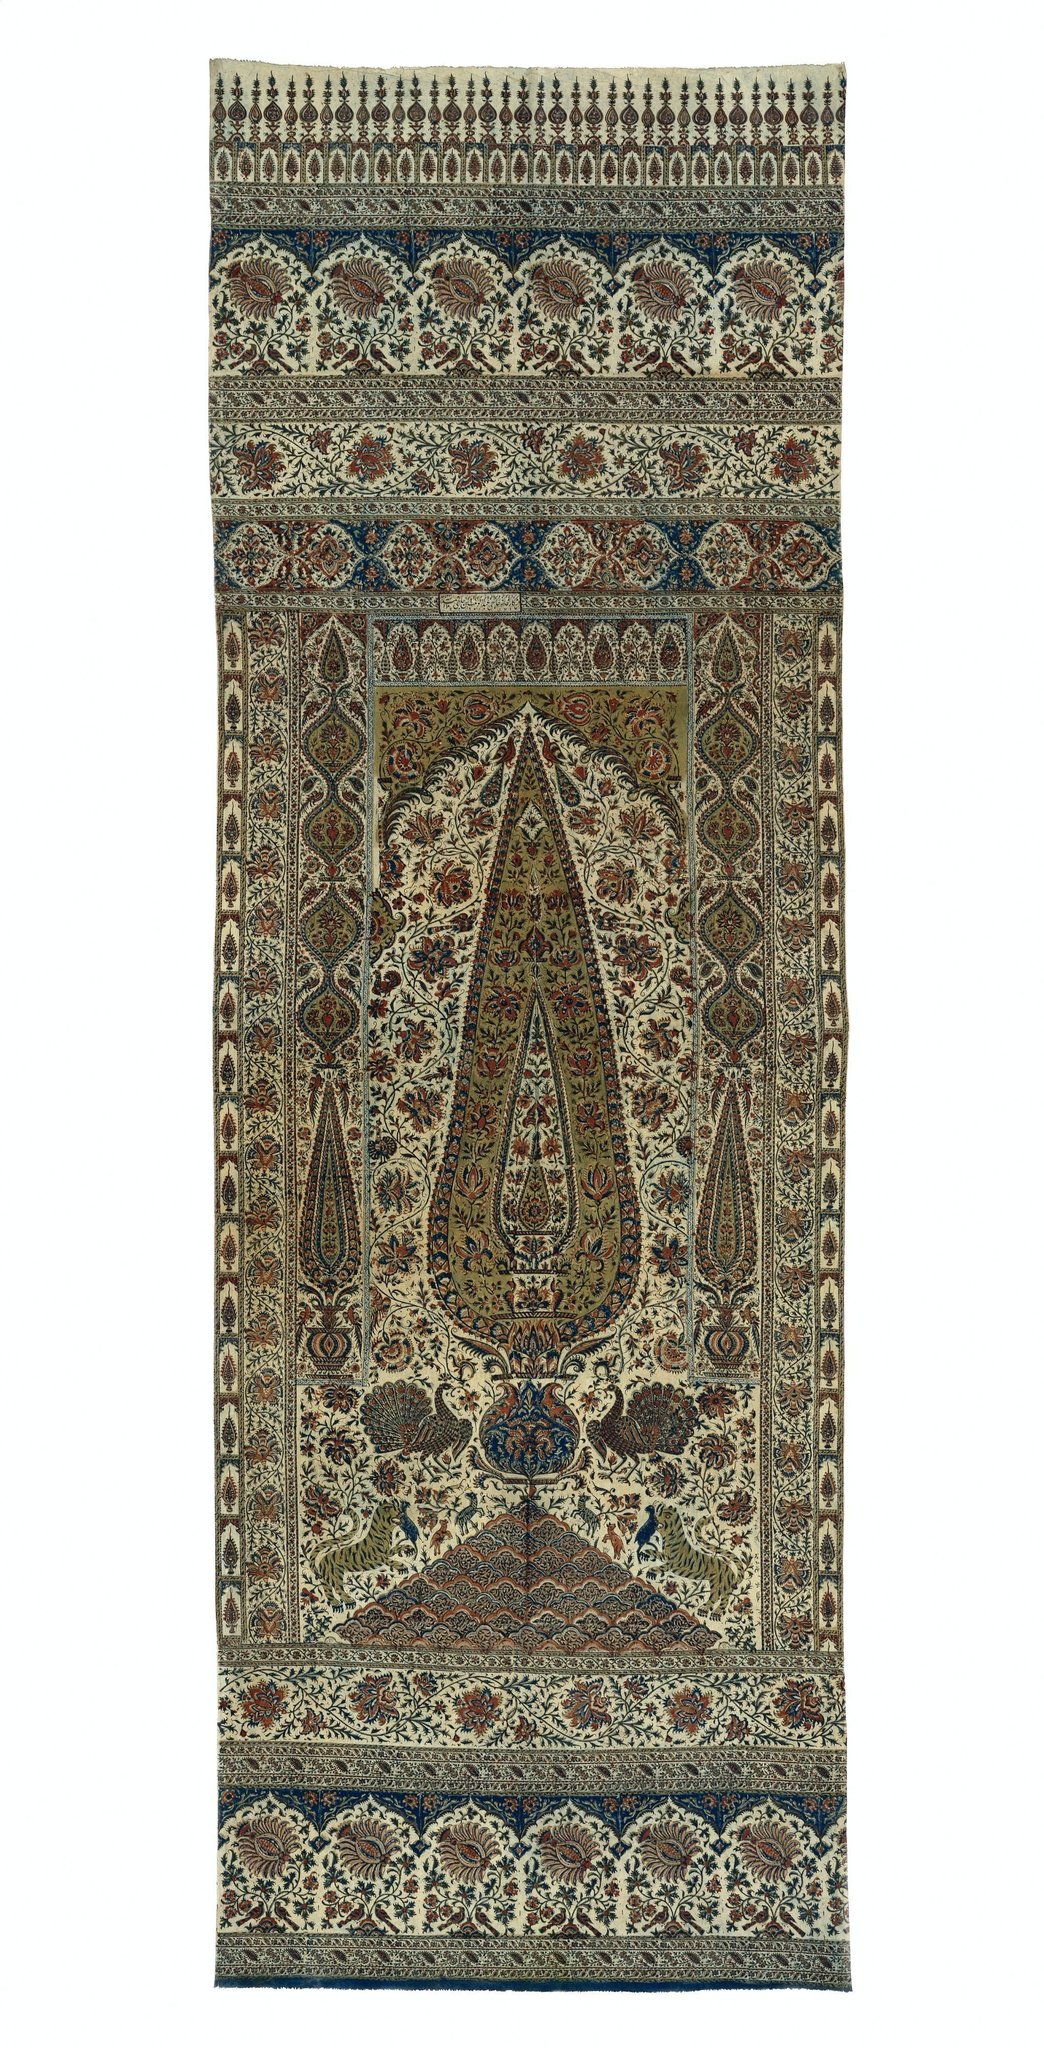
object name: woven material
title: Bedspread with a cypress-shaped, tree pattern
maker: Anonymous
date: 1600-1799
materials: cotton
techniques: printing block, weave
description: Chintz is a multicoloured cotton fabric produced in India and decorated by means of a woodblock print, and hand-painted floral and other motifs. Chintz was imported into Europe in the 17th century by the Dutch East India Company, and in large quantities brought to Persia (Iran), Siam (Thailand), Indonesia, China and Japan. The main pattern on this bedspread is an Indian form of the ‘tree of life.’